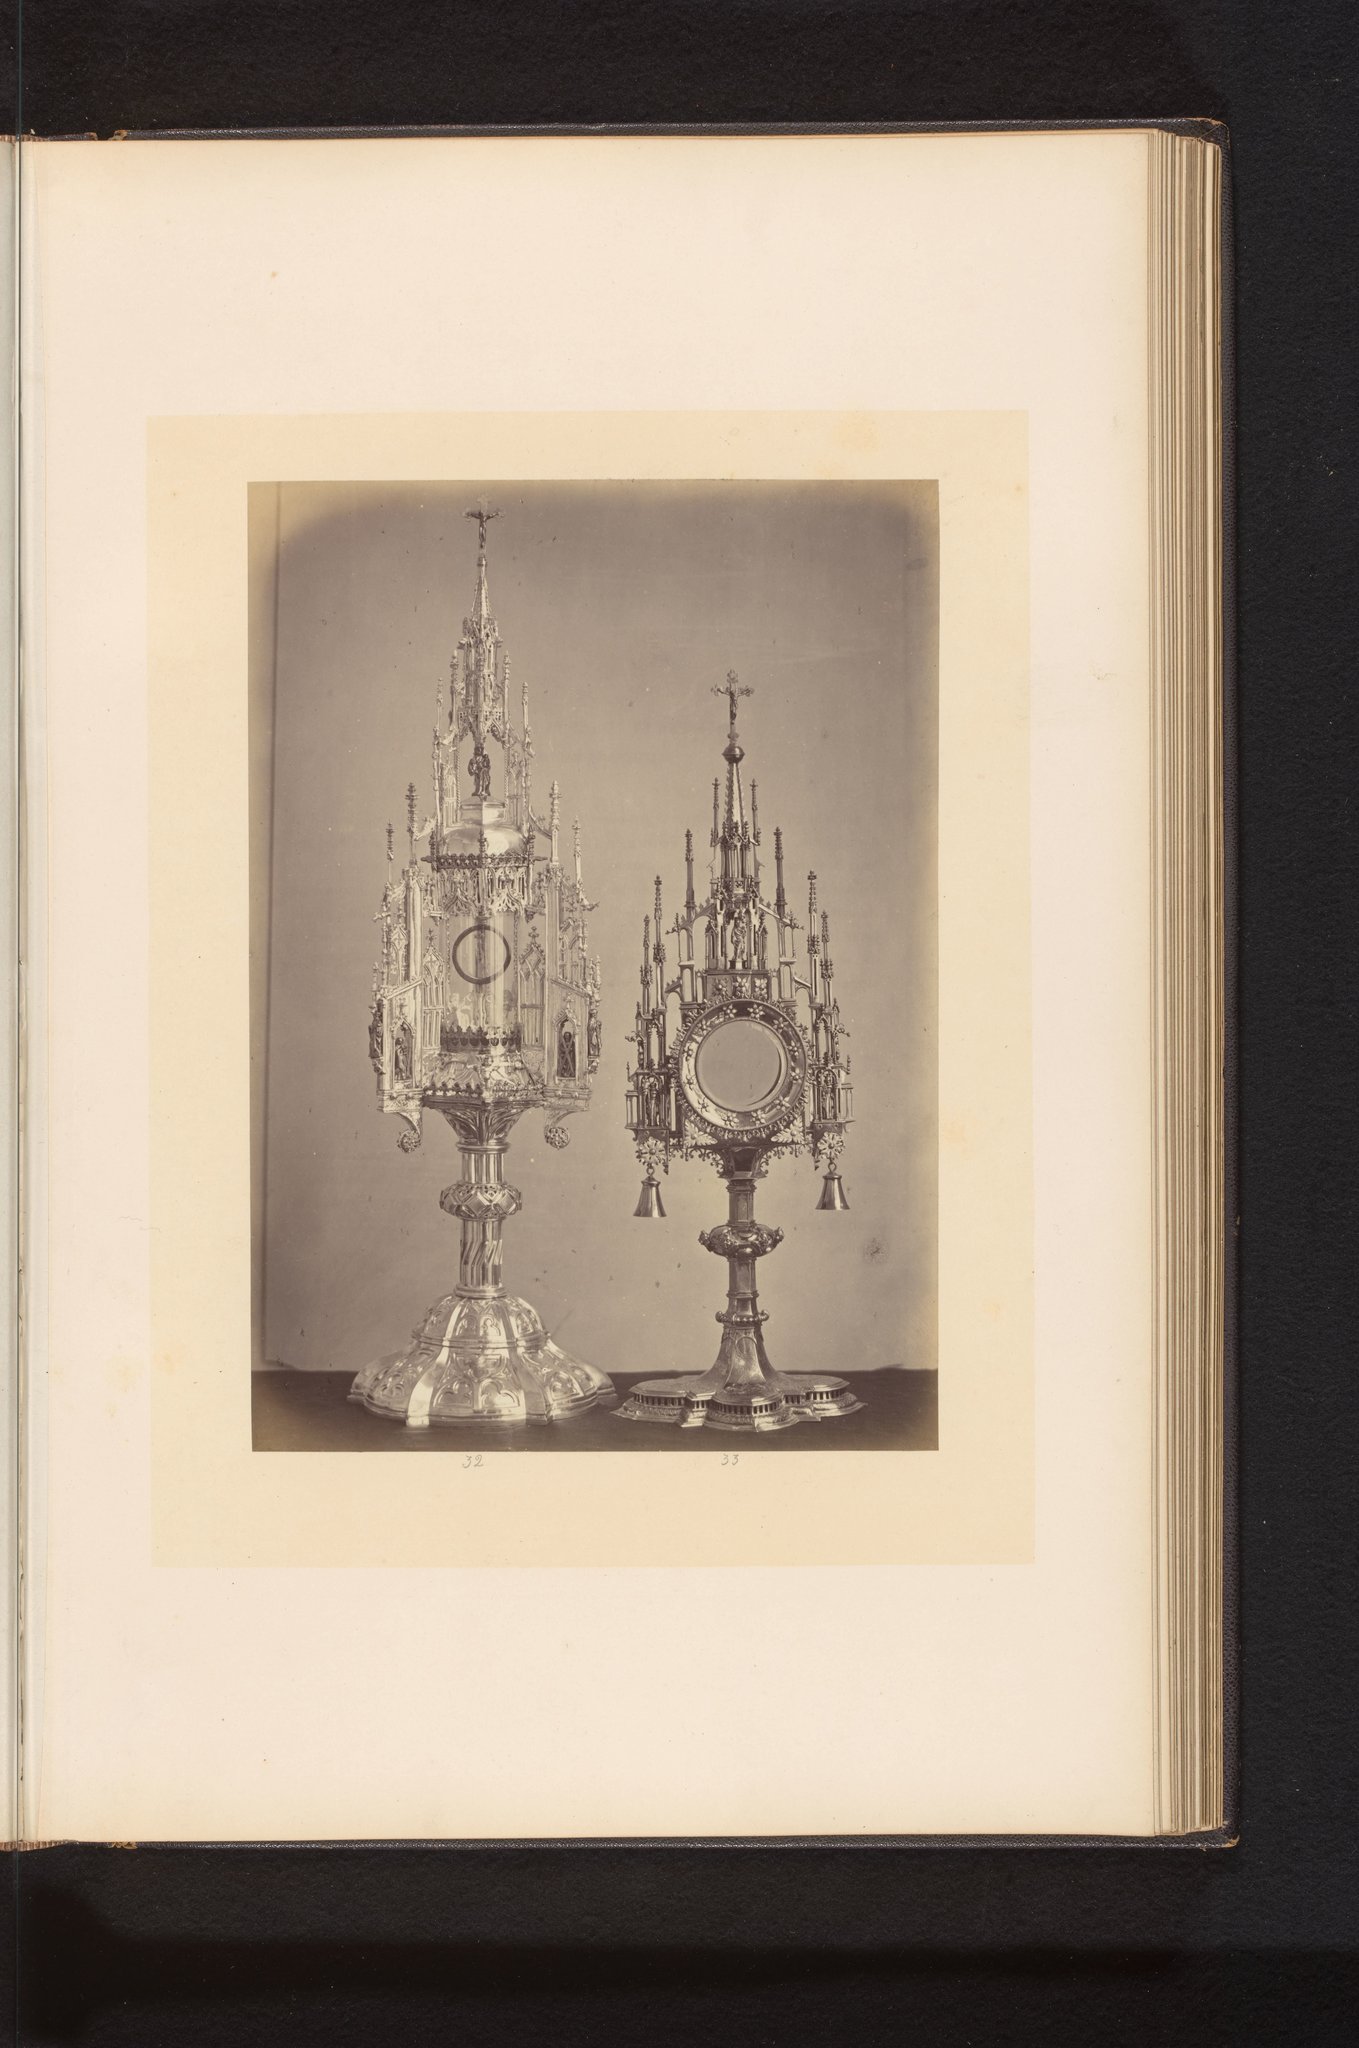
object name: page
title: Twee deels vergulde zilveren monstransen, opgesteld op een tentoonstelling over religieuze objecten uit de middeleeuwen en renaissance in 1864 in Mechelen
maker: joseph maes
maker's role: fotograaf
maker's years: 1838-1908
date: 1864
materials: photographic support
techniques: albumen print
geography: mechelen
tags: ostensorium, monstrance, mechelen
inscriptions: number: ‘32 - 33’